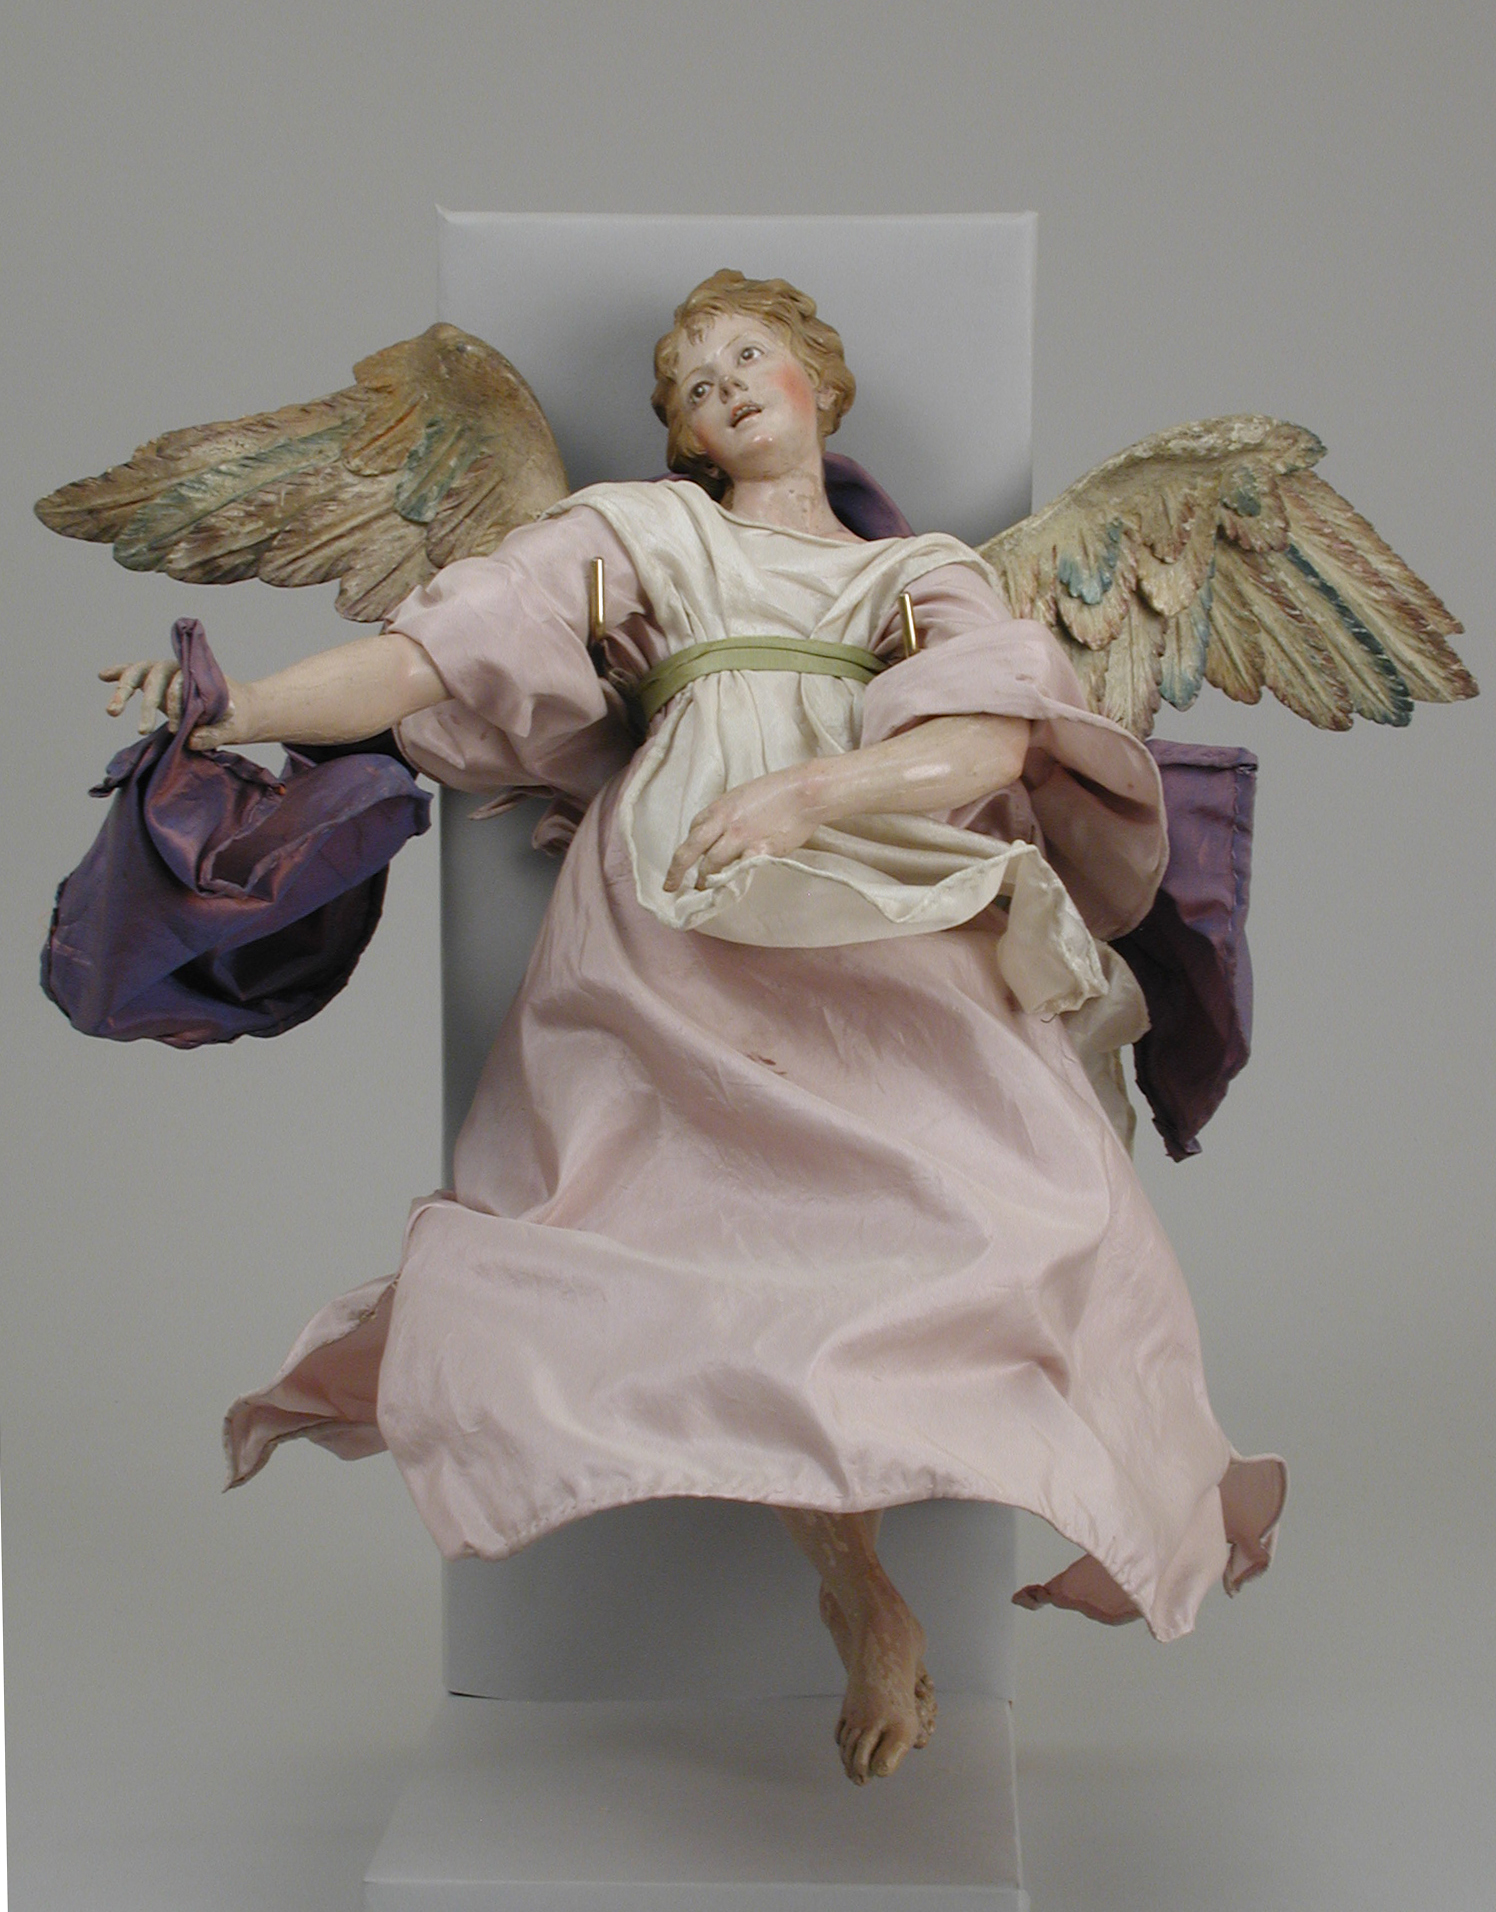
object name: crèche figure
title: Angel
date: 1751-1800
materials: terracotta, fiber, metal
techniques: polychrome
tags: angels